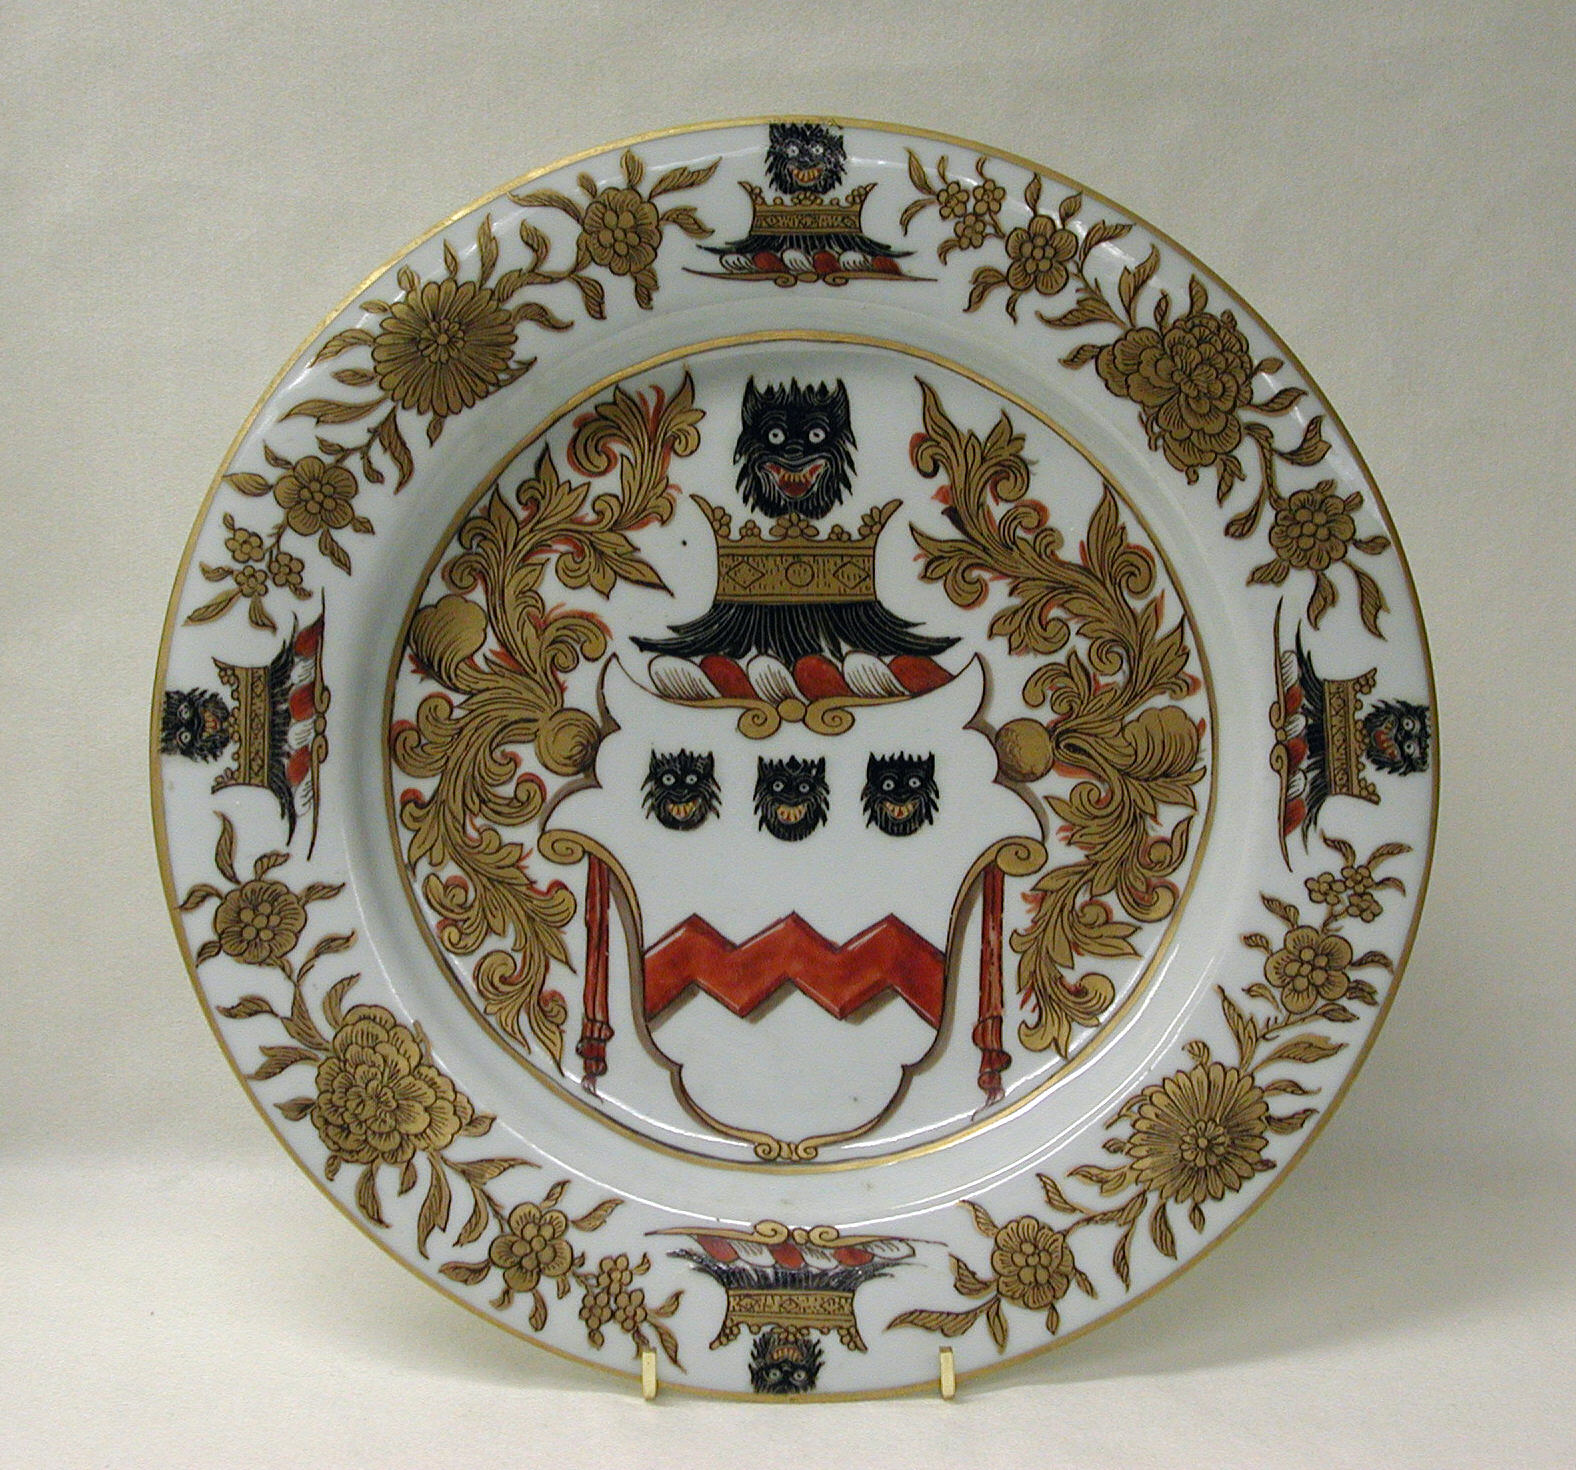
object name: plate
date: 1730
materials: hard paste porcelain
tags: flowers,coat of arms